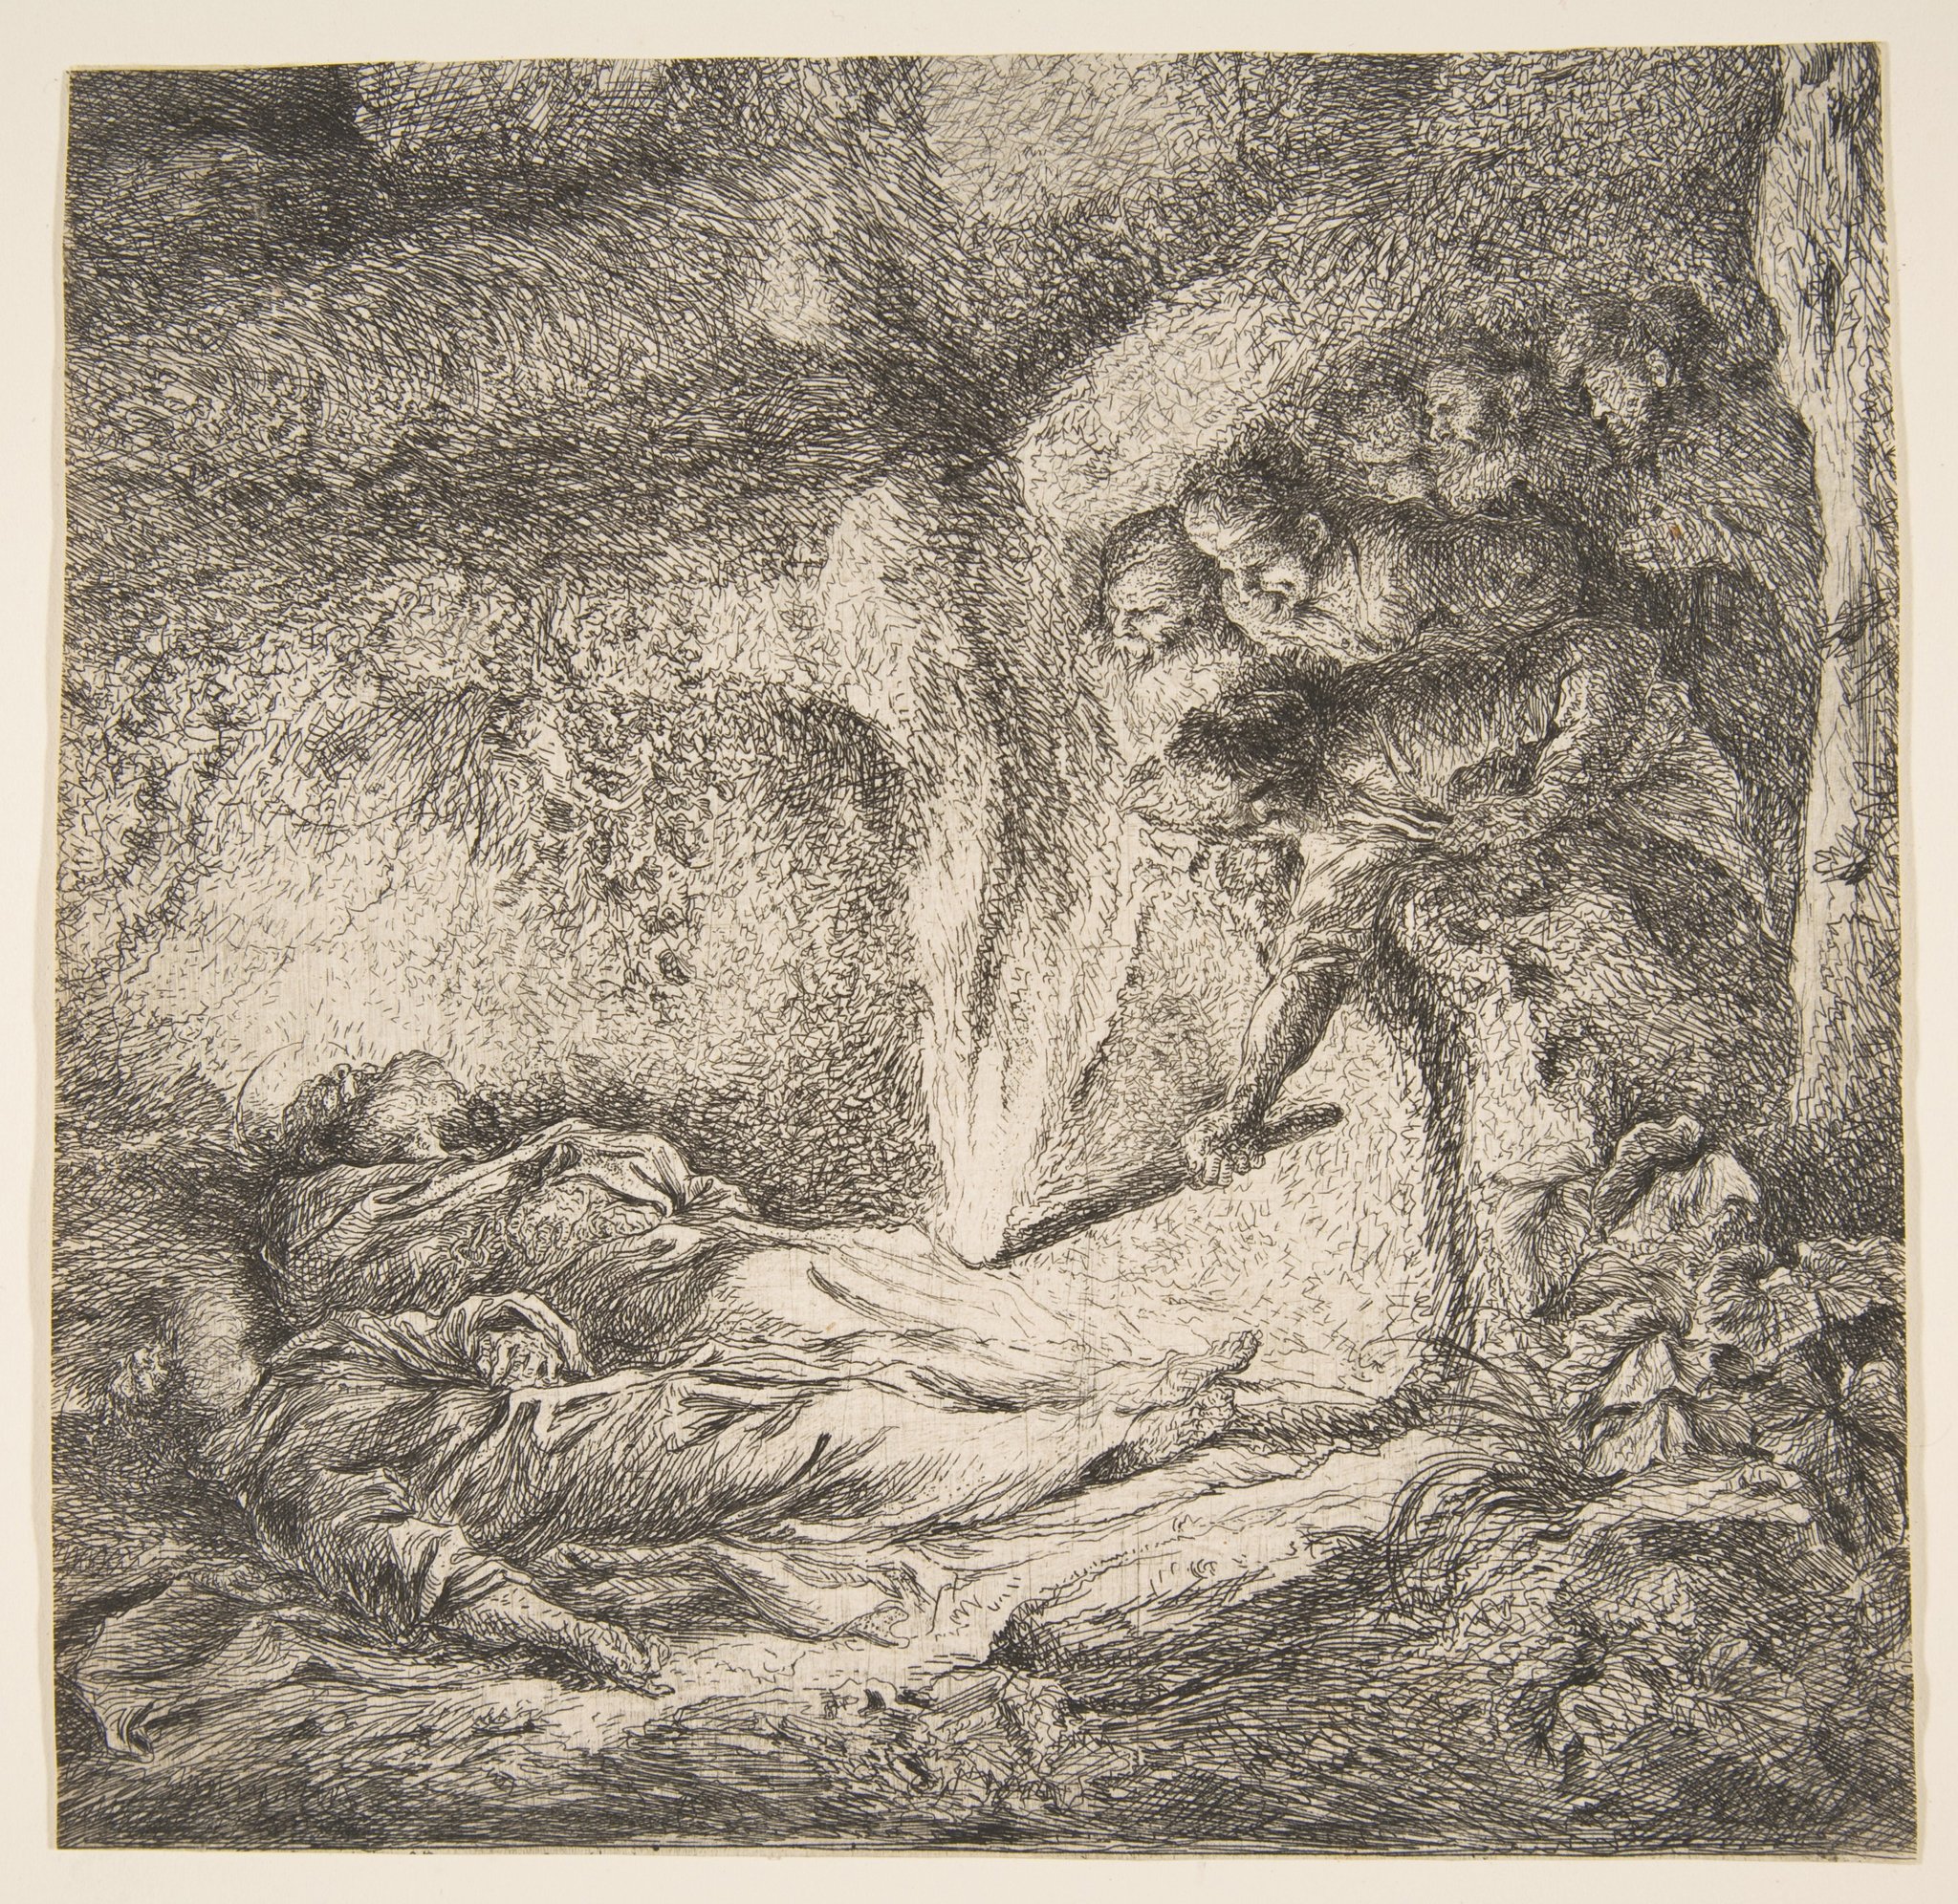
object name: print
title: Finding the bodies of Saints Peter and Paul (fragment)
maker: giovanni benedetto castiglione (il grechetto)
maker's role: artist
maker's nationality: italian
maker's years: 1609-1664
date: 1647-1651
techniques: etching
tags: men,saint paul,saint peter,death